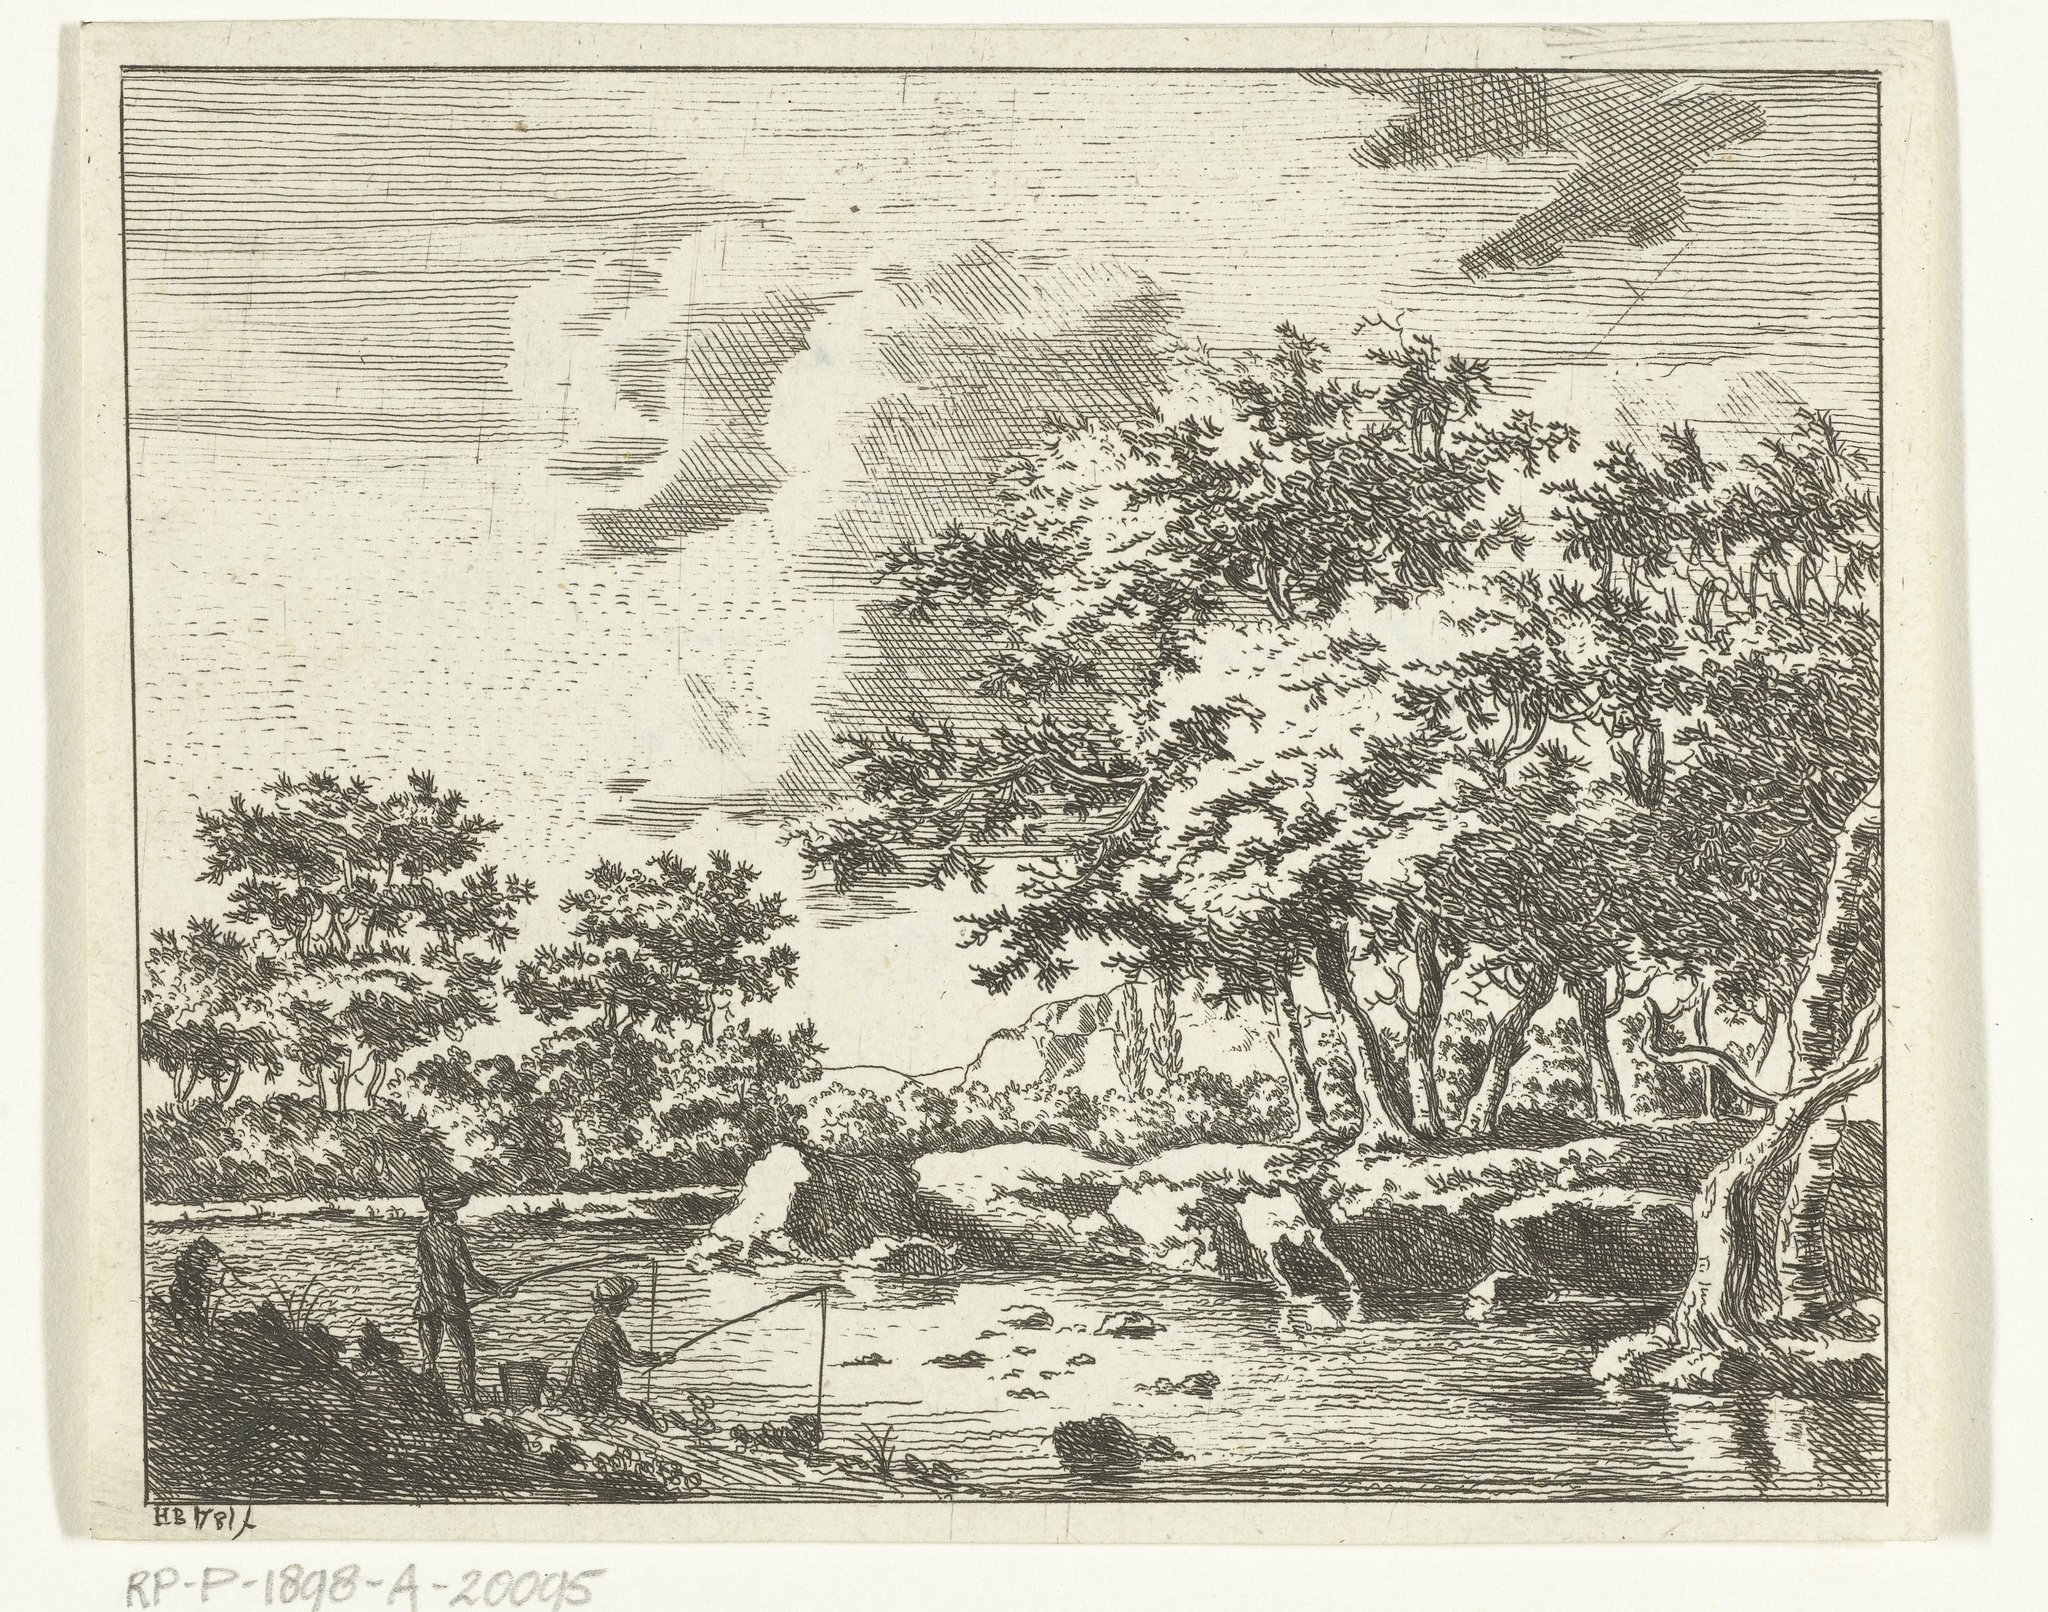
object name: print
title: Landschap met twee vissers bij rivier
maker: hendrik berg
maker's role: print maker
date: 1781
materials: paper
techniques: etching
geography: netherlands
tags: river, angling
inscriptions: collector's mark: Lugt 2228